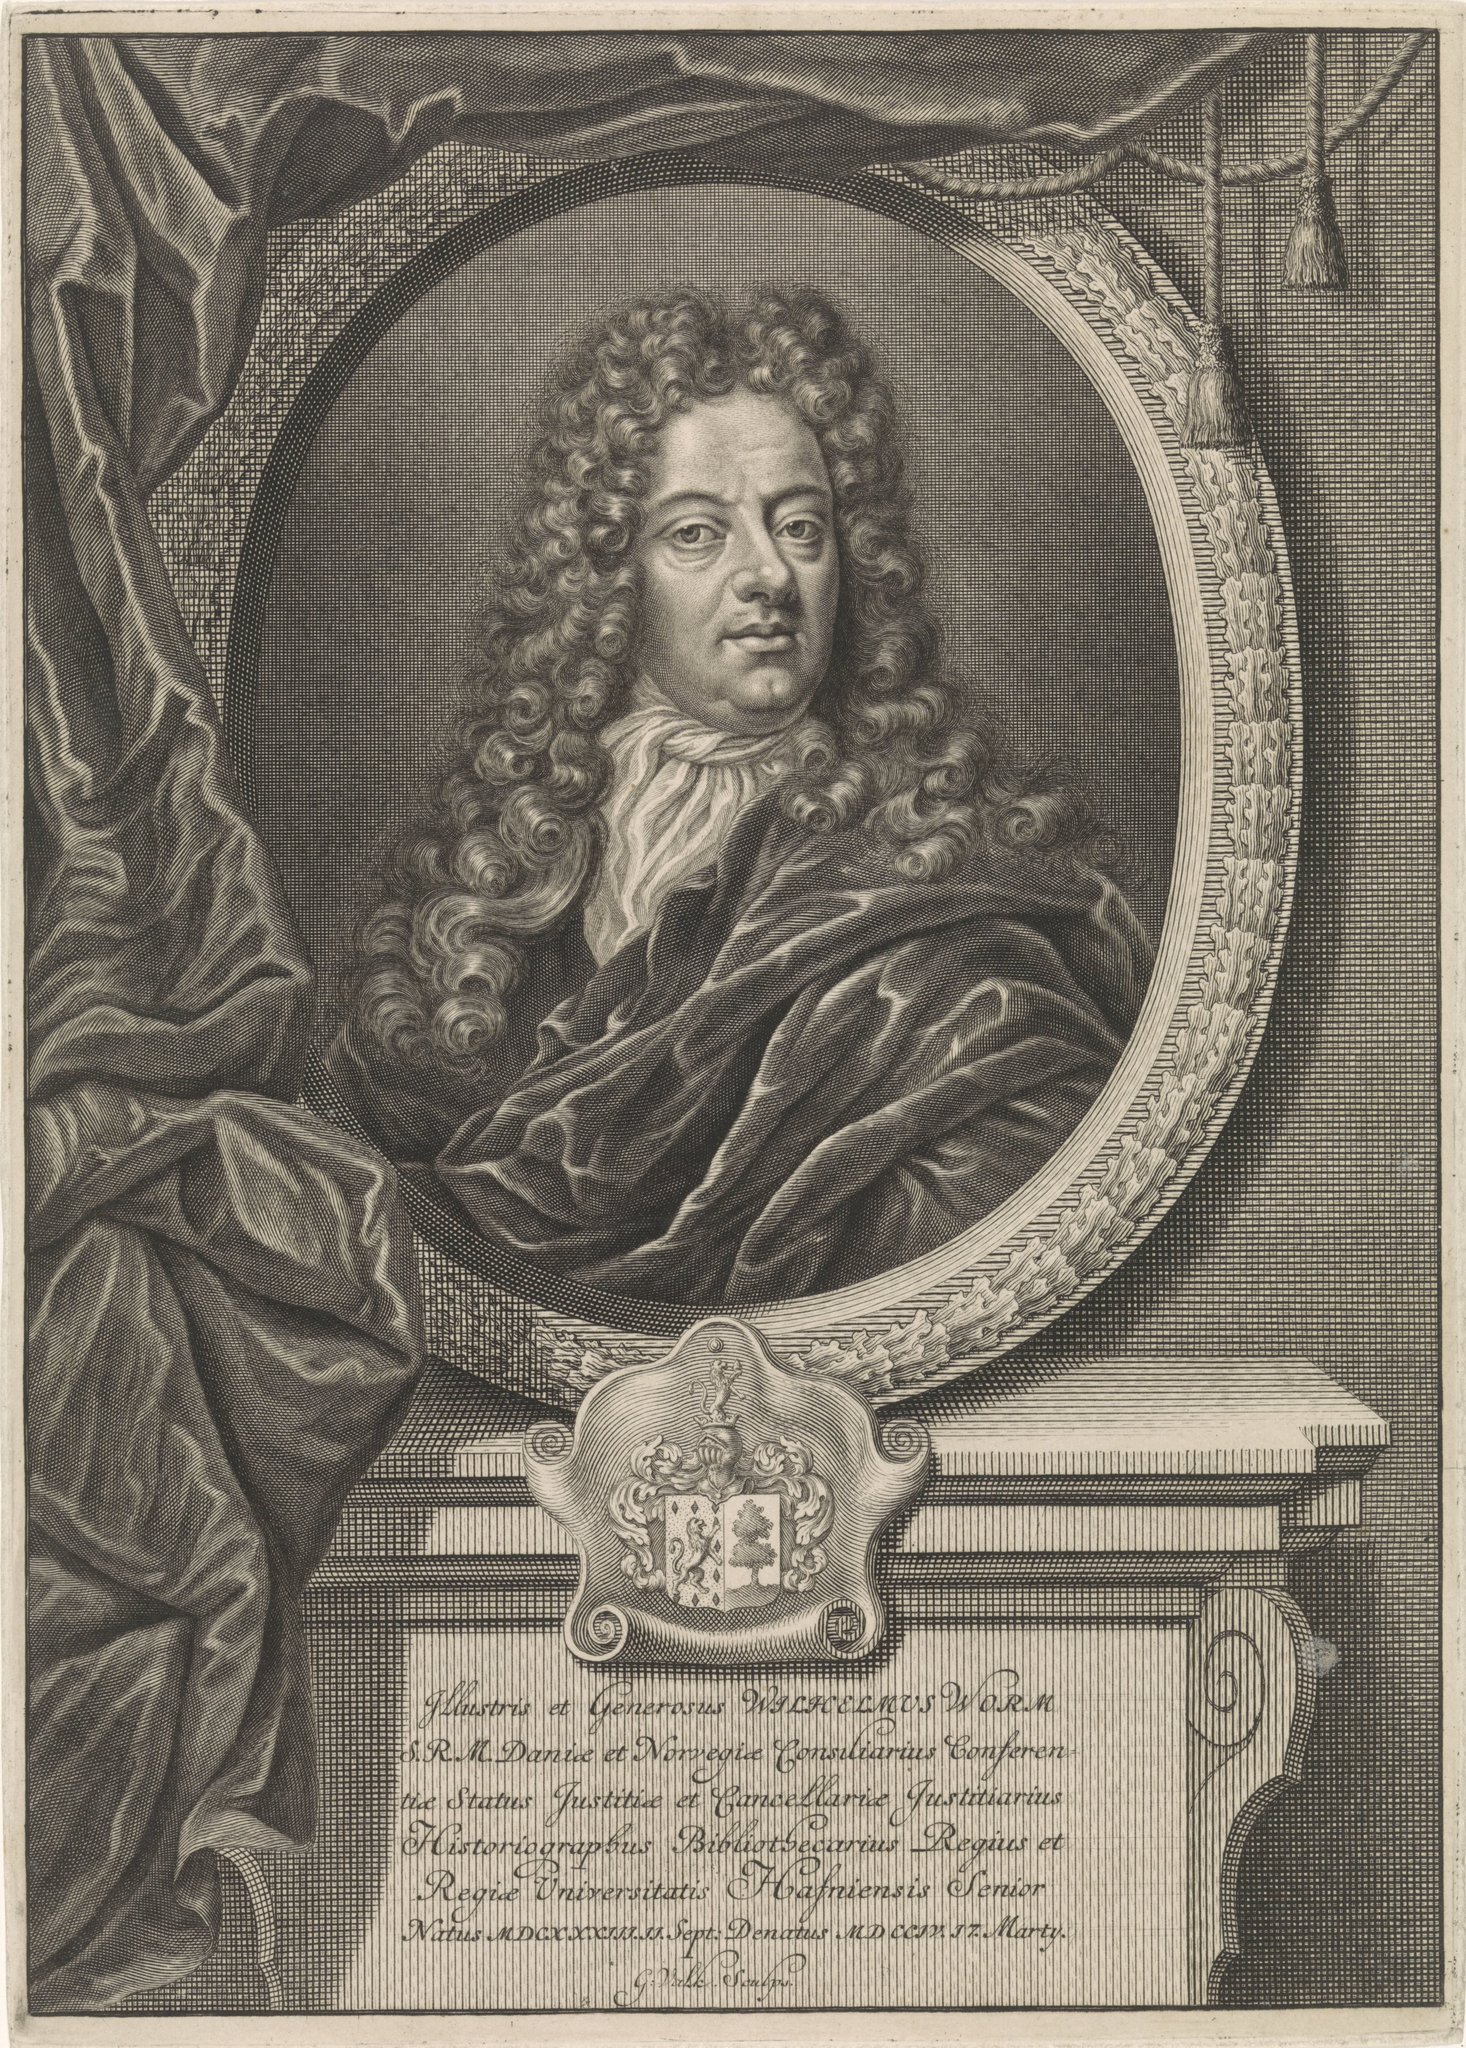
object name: print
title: Portret van Wilhelmus Worm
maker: gerard valck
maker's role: print maker, publisher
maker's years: 1651-1726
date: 1704-1726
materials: paper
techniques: engraving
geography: amsterdam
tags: wilhelmus worm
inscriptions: collector's mark: Lugt 2228